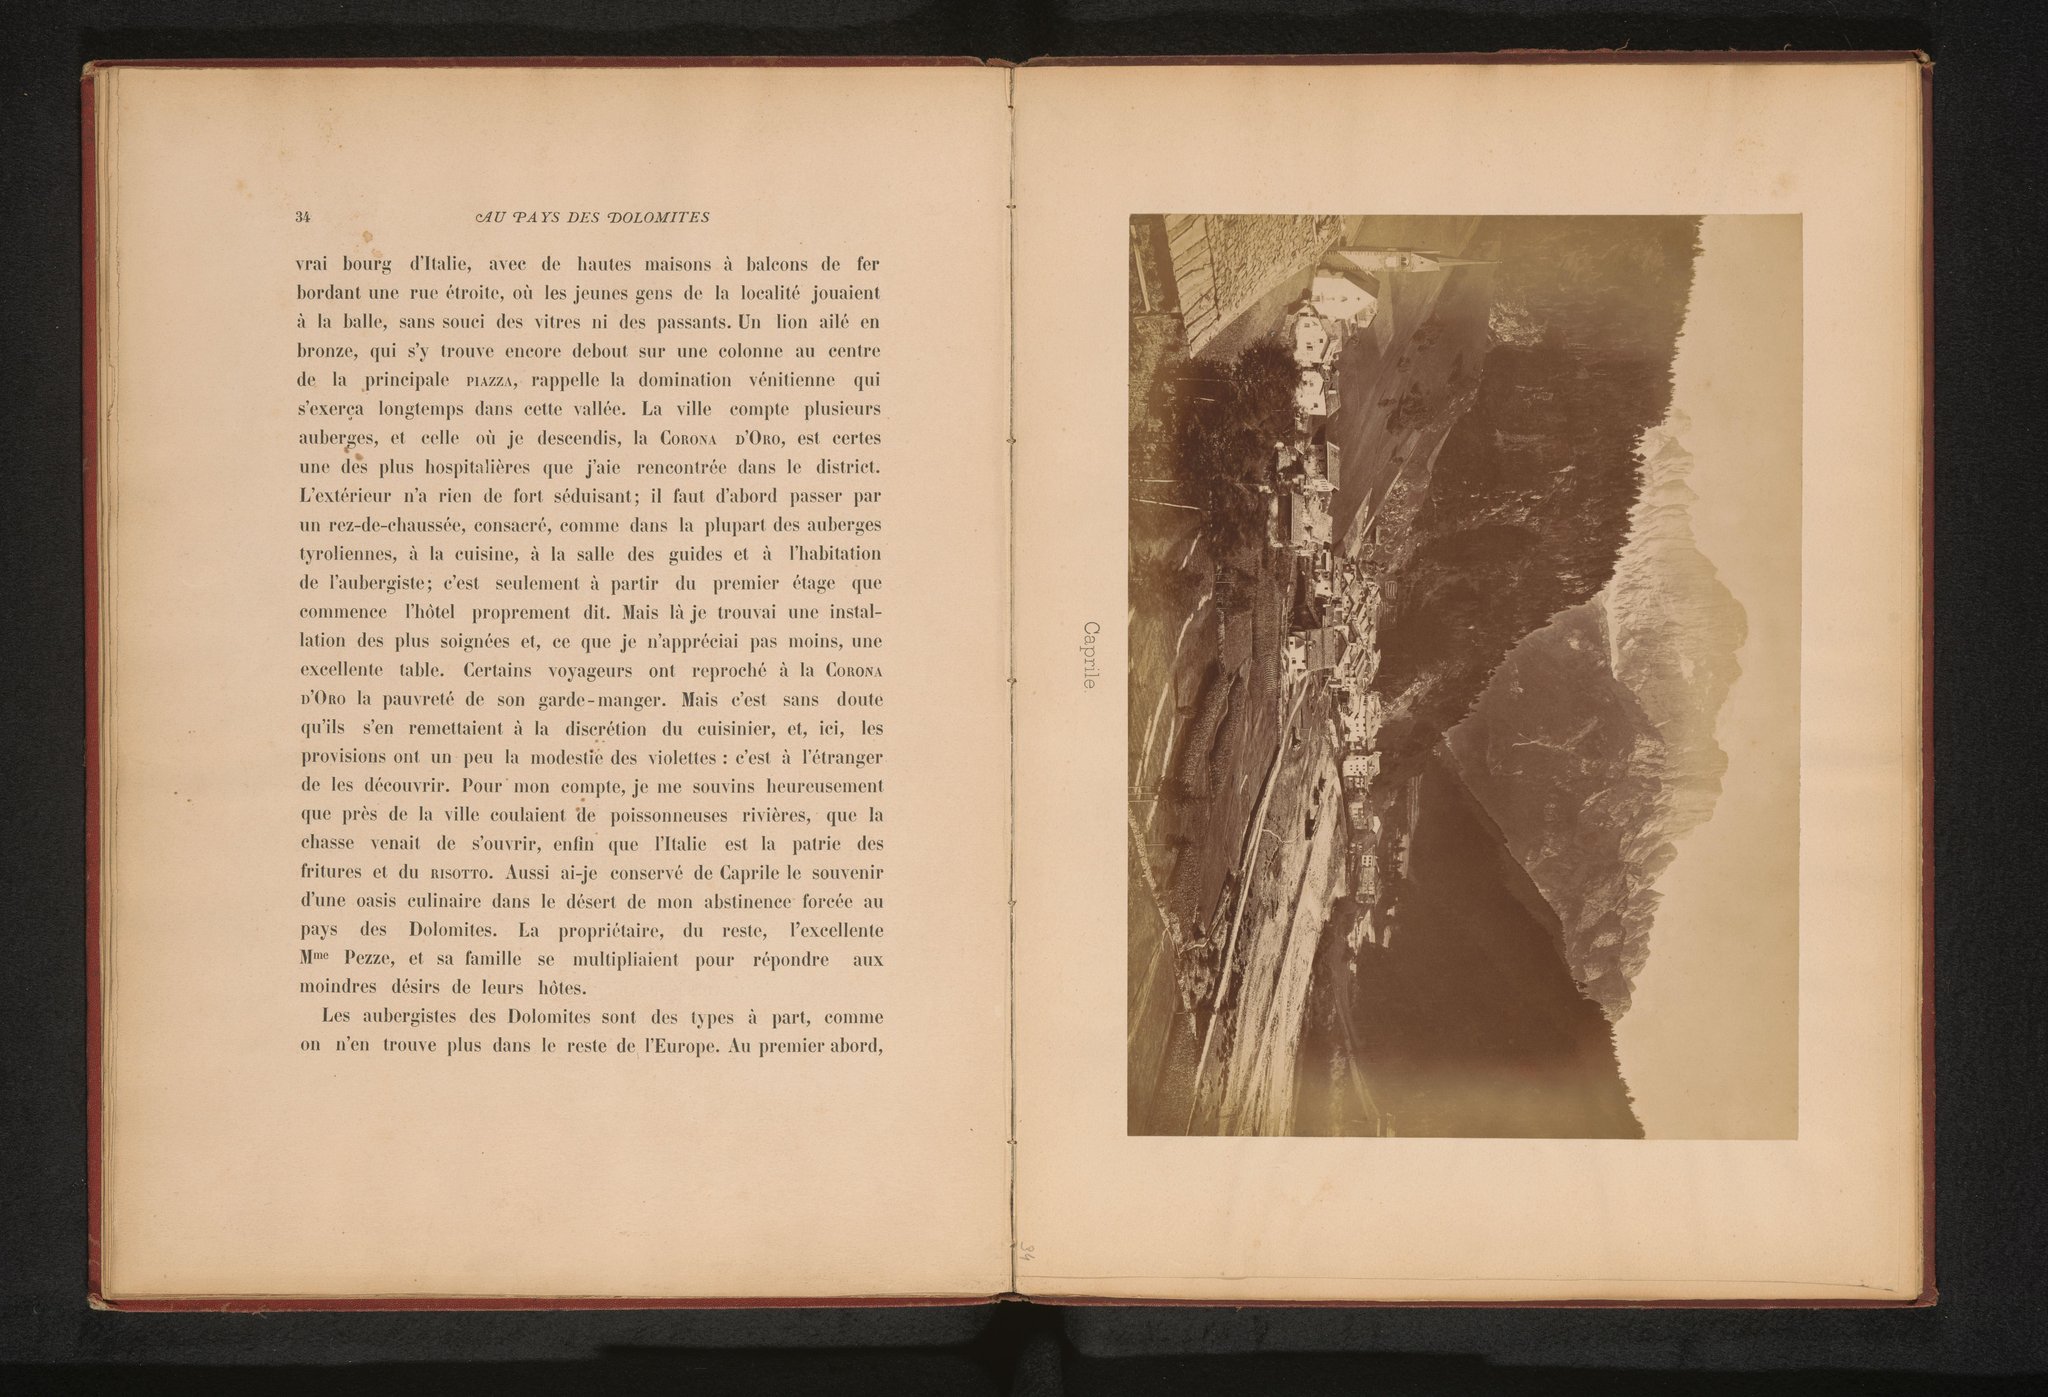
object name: photograph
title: Gezicht op Caprile in de Dolomieten, Italië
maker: eugène goblet dalviella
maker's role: politician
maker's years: 1846-1925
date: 1873-1878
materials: photographic support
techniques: albumen print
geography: dolomites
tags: prospect of village, silhouette of village, mountain-range, snow peaks, mountains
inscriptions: number: ‘34’